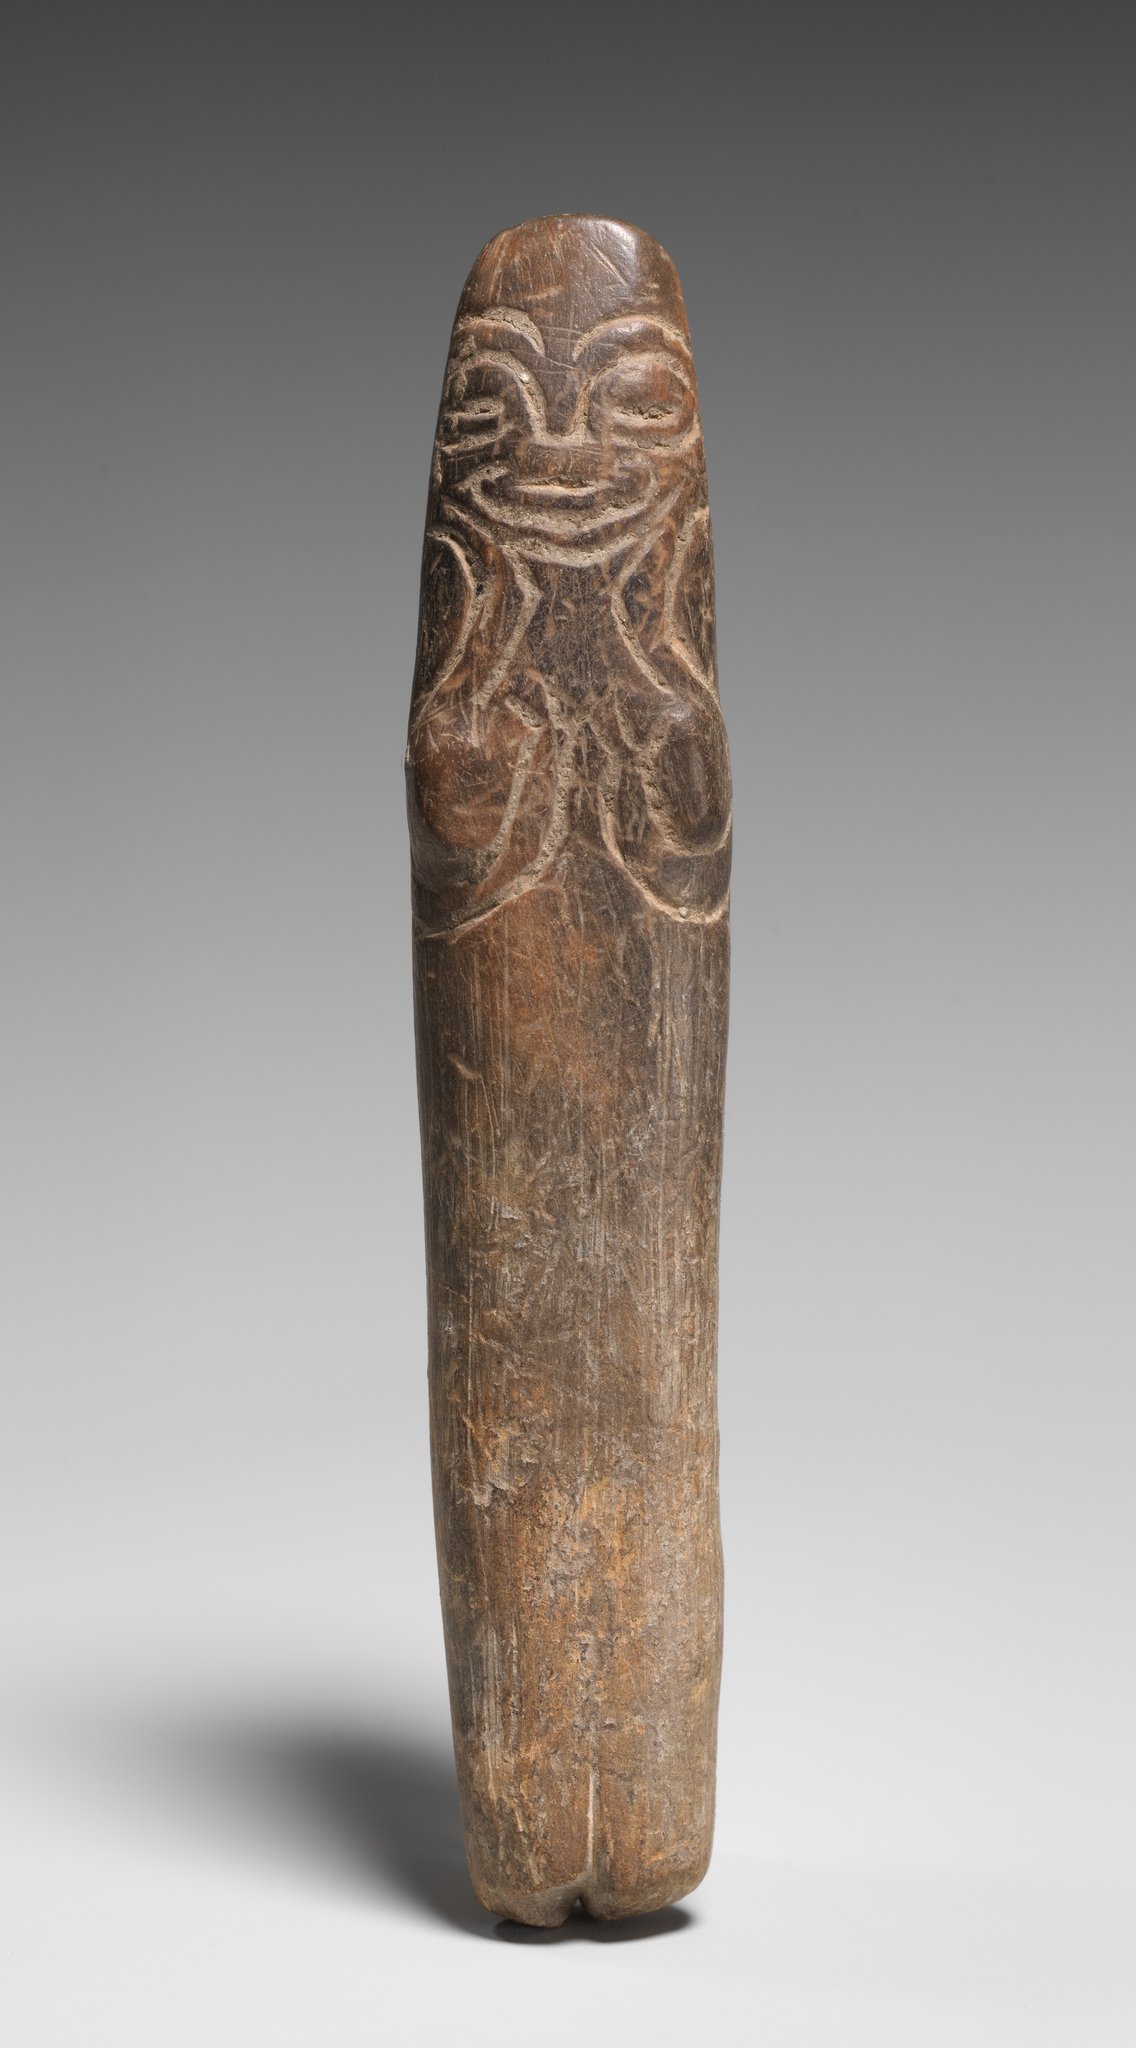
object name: human figure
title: Abstract Stone Figure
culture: valdivia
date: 2333-2001 BCE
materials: stone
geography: ecuador